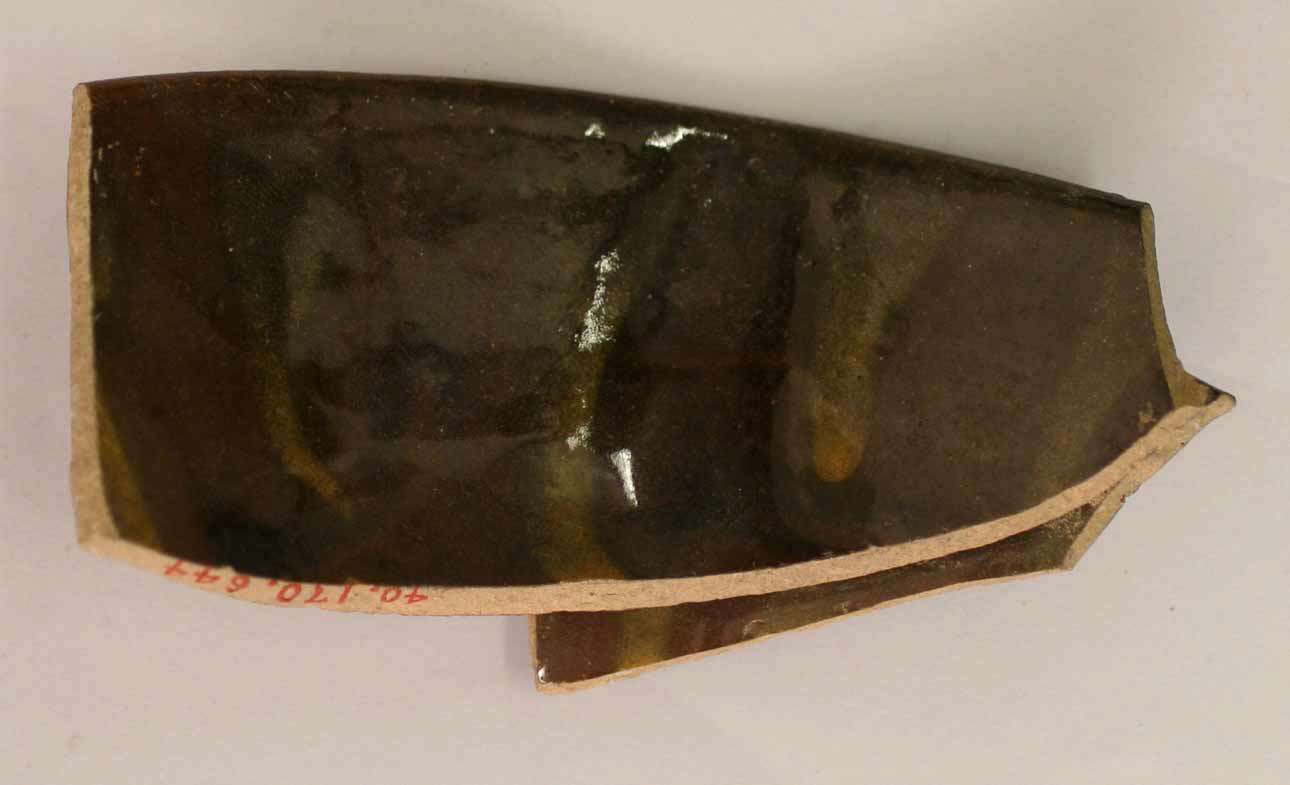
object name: waster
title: Waster of Three Bowls Attached Together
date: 1501-1700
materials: earthenware, glaze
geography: iran